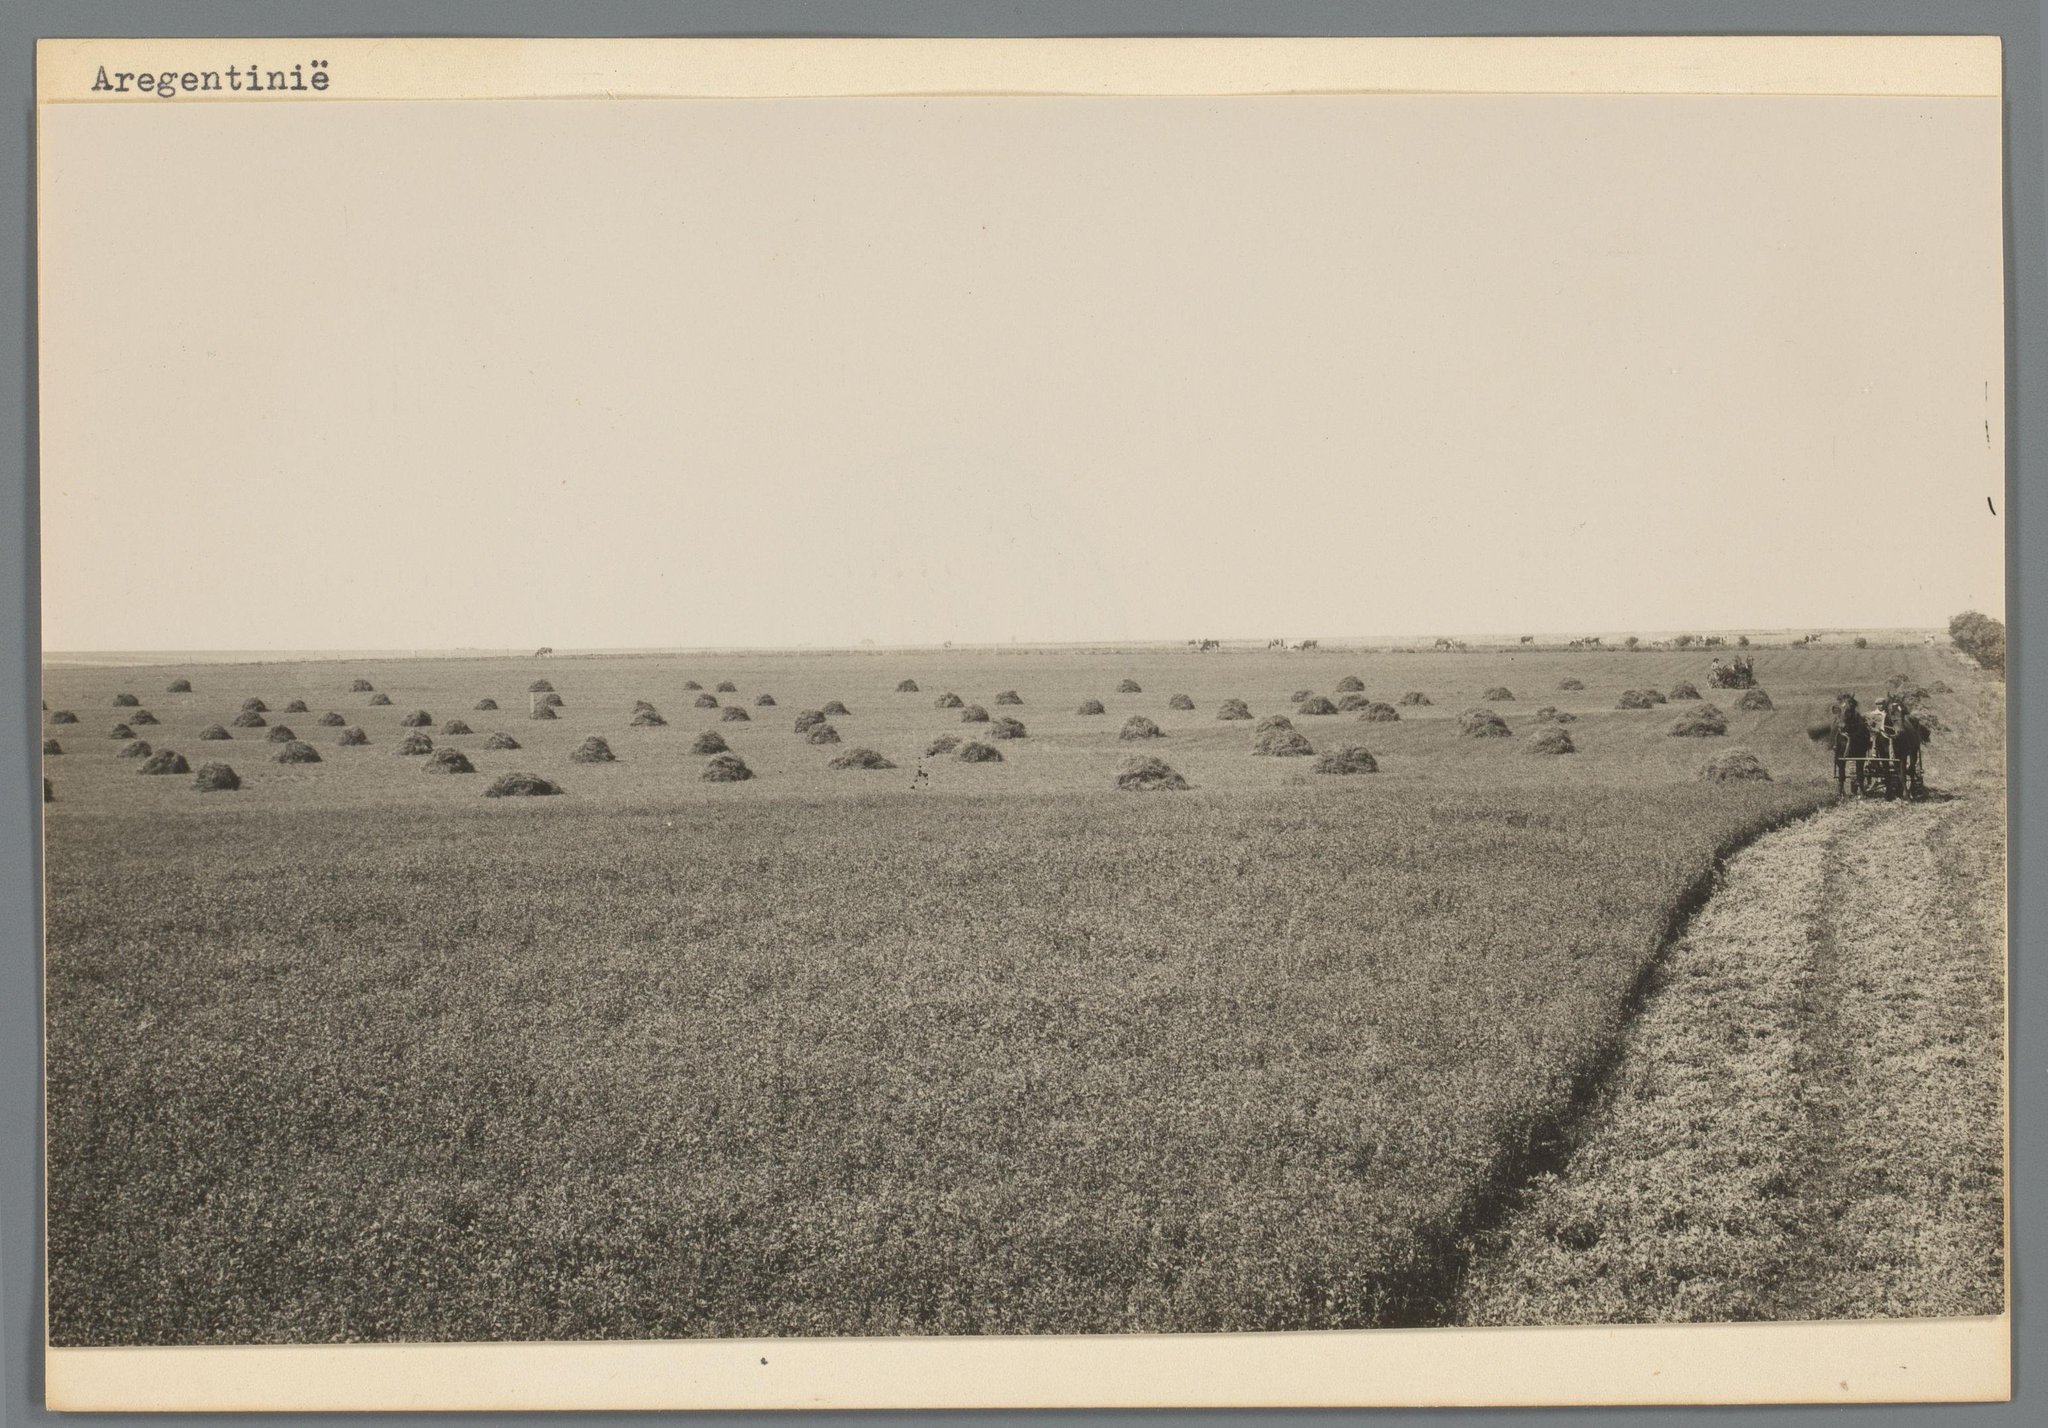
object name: photograph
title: Gezicht op een veld tijdens het oogsten van luzerne, Argentinië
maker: Anonymous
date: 1900-1930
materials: paper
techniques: gelatin silver print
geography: argentinië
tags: stocking (on the field), reaping, picking, mowing ~ harvest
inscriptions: number: ‘4303’, inscription: ‘Alfalfa-velden’, number: ‘970000’, stamp: ‘REPÚBLICA ARGENTINA/ MINISTERIO D'AGRICULTURA DE LA MACIOR/ [...]/ DIVISION FOTO-CINEMATOGRAFIA’, number: ‘40.903’